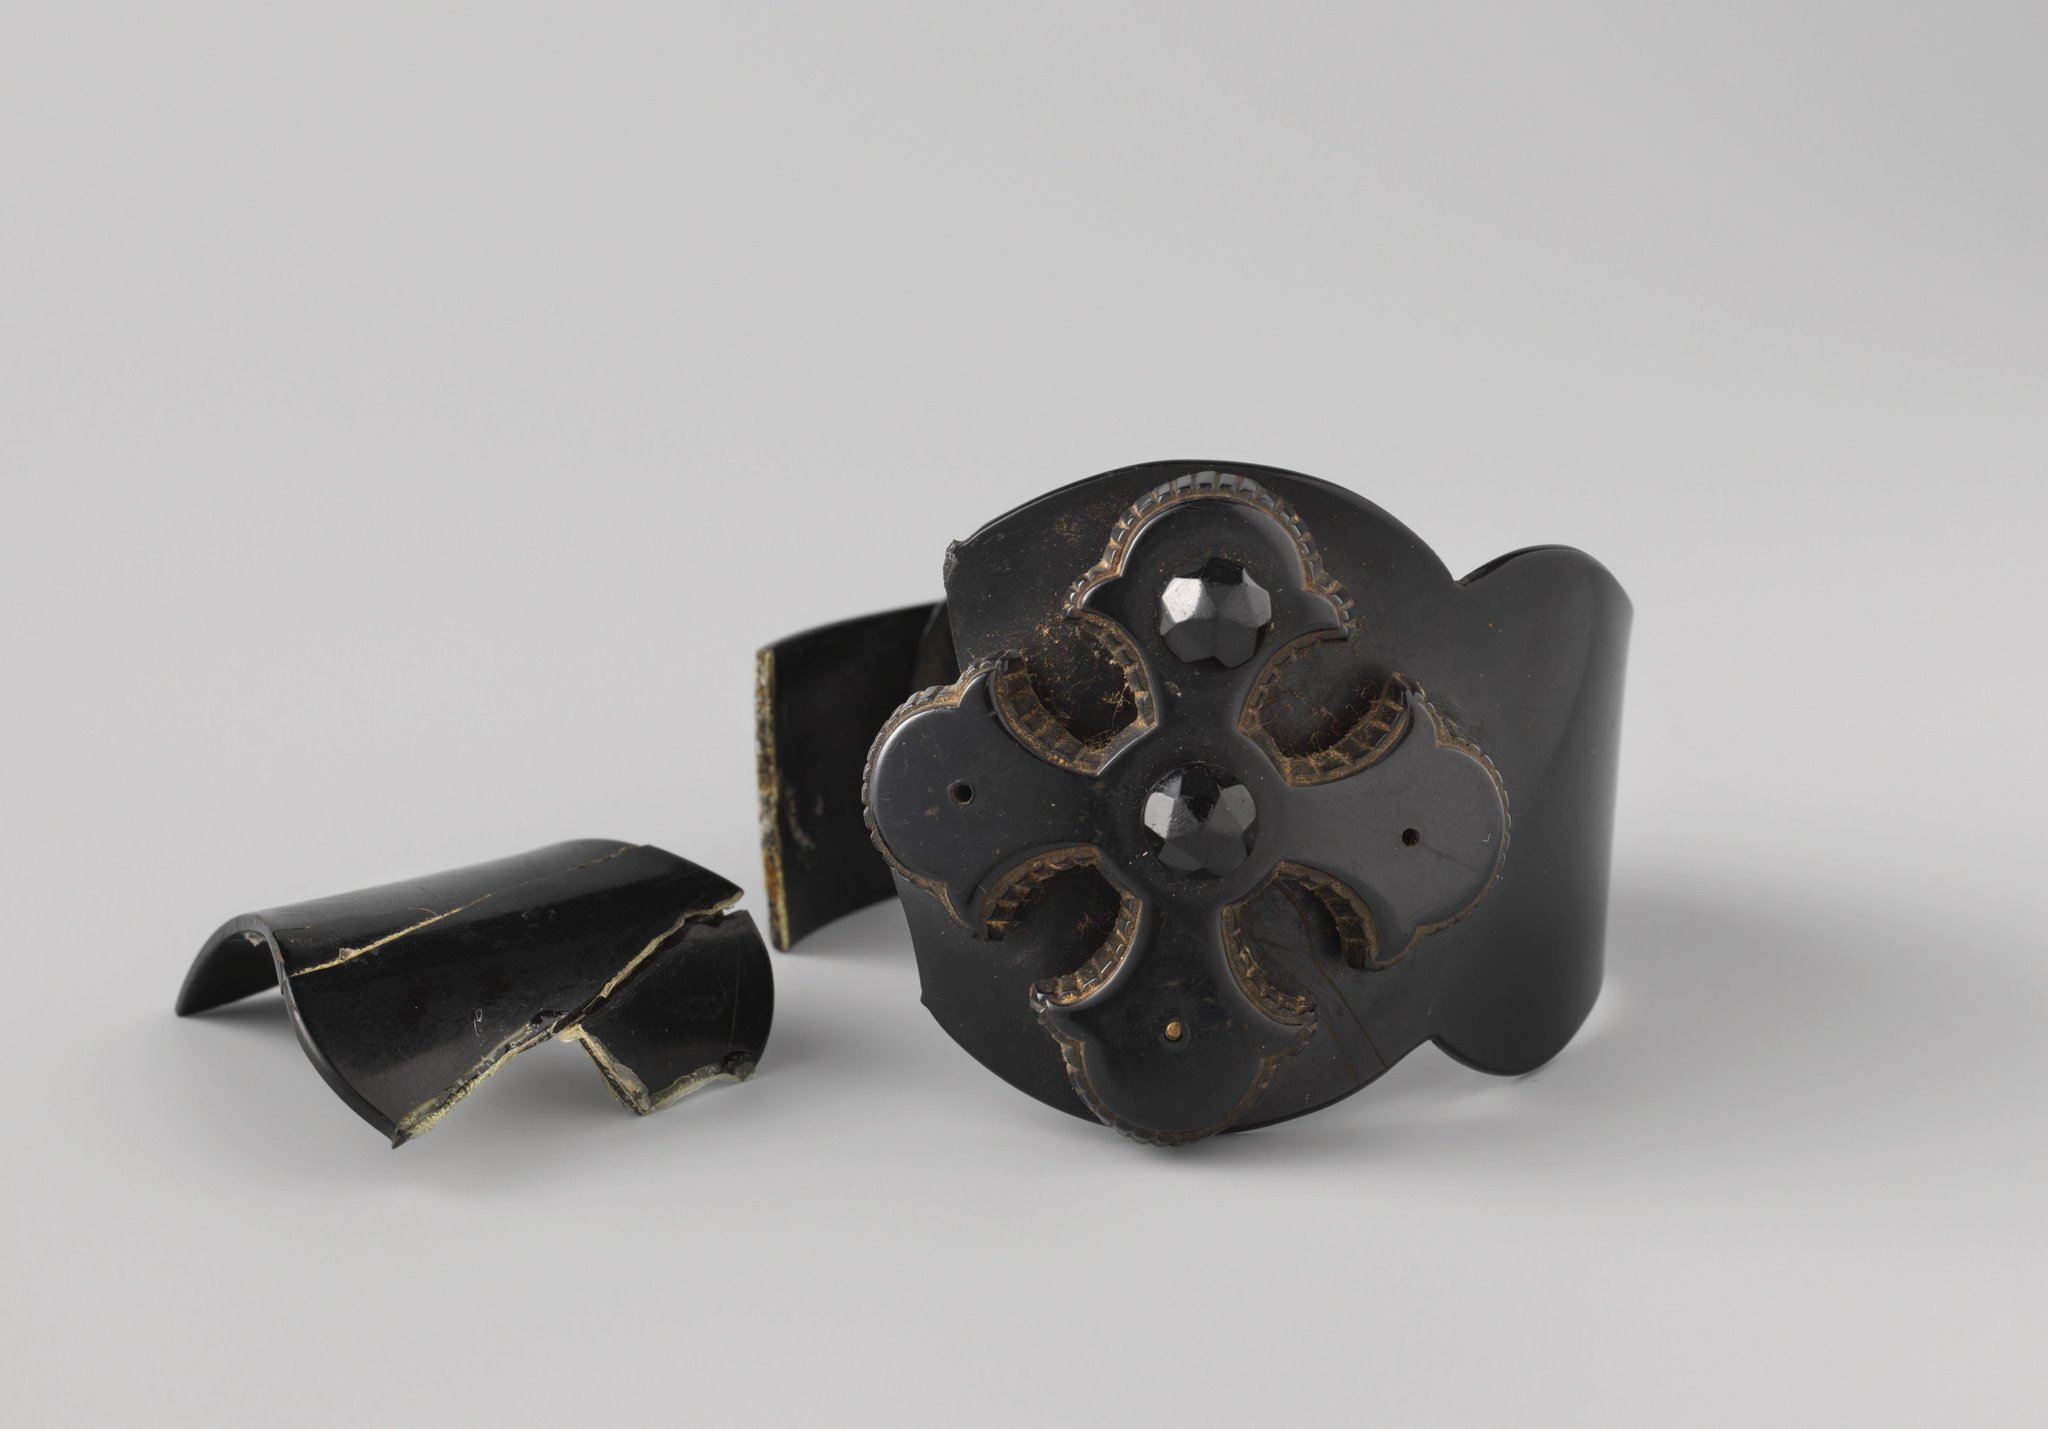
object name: bracelet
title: Armband van balein, breed van voren en enigszins gegolfd. Op bovenkant een Grieks kruis; versierd met gitten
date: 1865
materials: baleen, jet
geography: great britain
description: Armband van balein, breed van voren en enigszins gegolfd. Op de bovenkant is een Grieks kruis bevestigd. Versierd met gitten, waarvan er drie ontbreken.